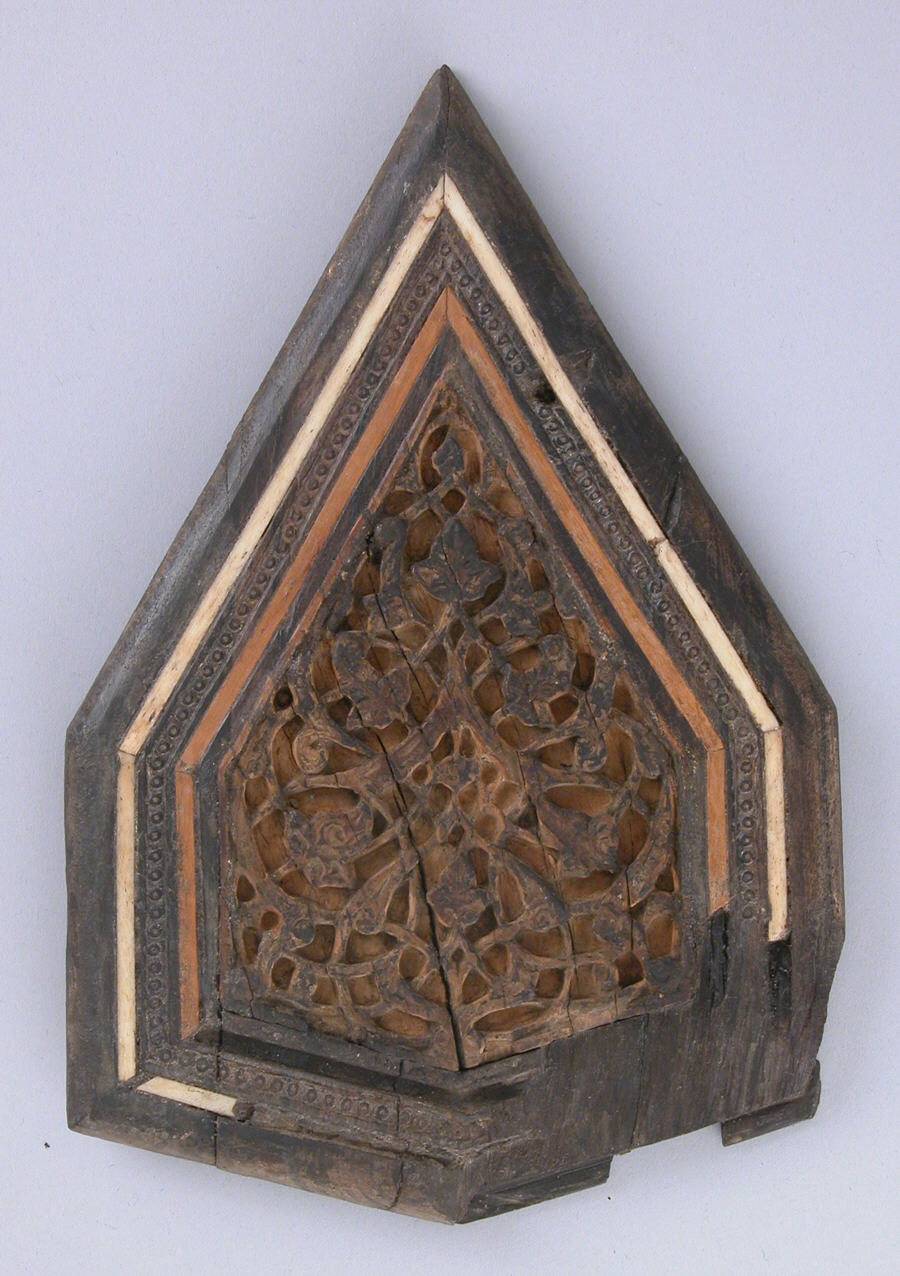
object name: panel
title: Panel from a Minbar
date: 1201-1400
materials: ivory, paint, wood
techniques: carving, inlay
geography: egypt